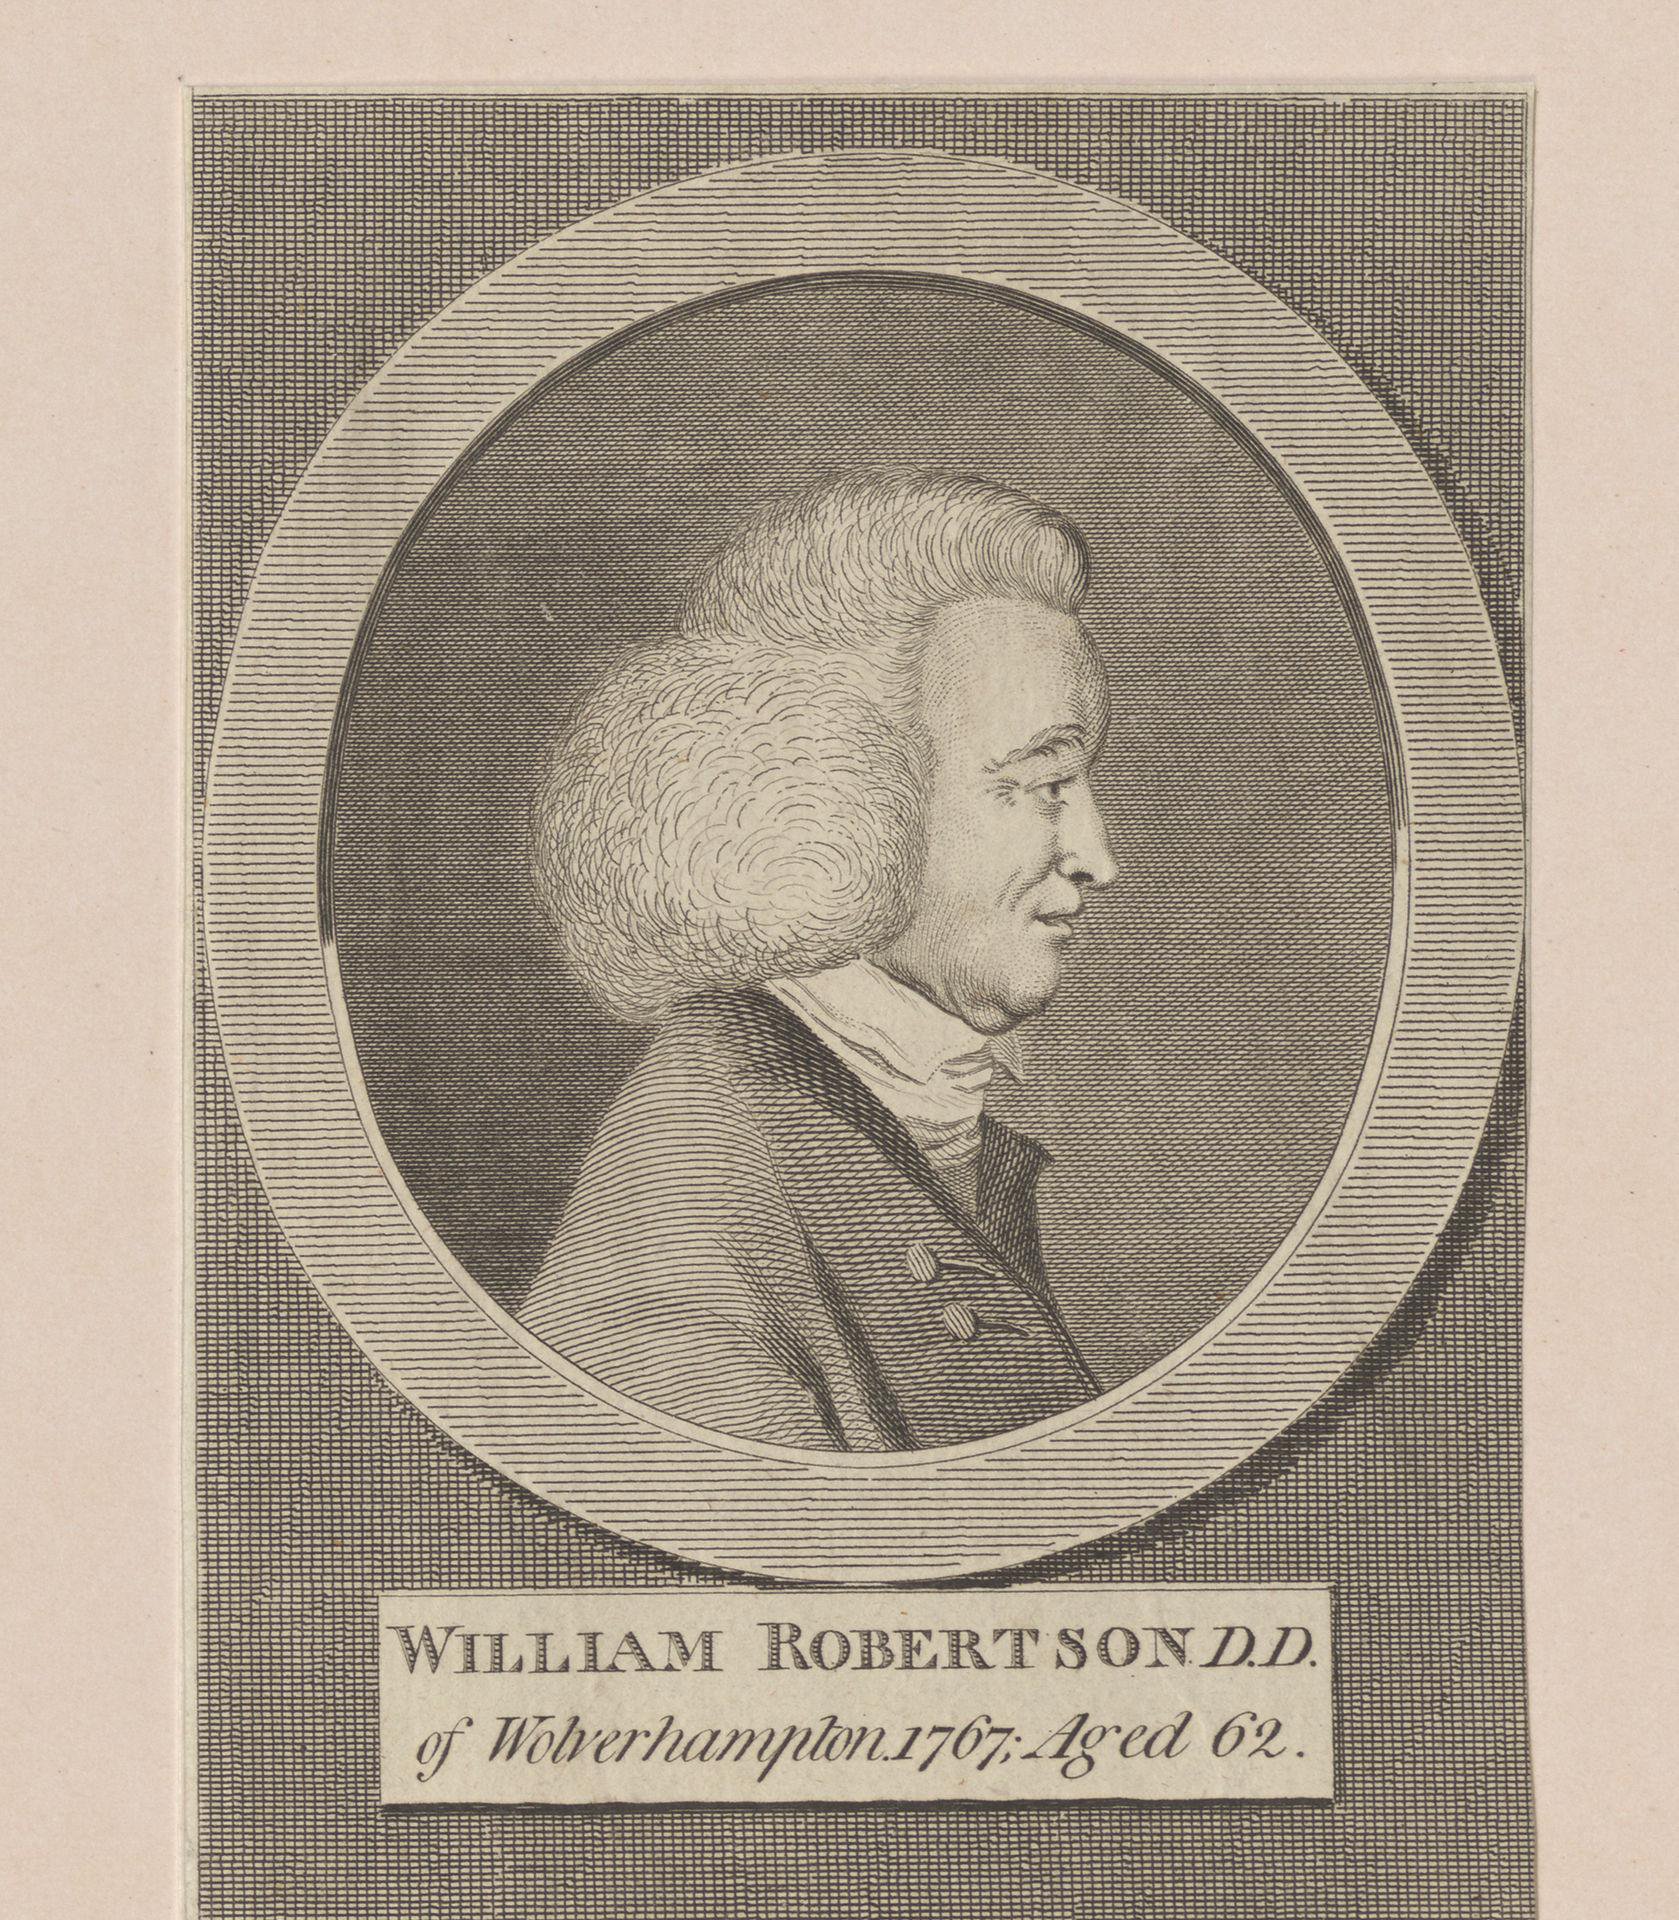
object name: print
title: Portret van William Robertson op 62-jarige leeftijd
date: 1709-1783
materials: paper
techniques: engraving, etching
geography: london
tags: historical persons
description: Prent uit: The Gentleman's Magazine, september 1783.